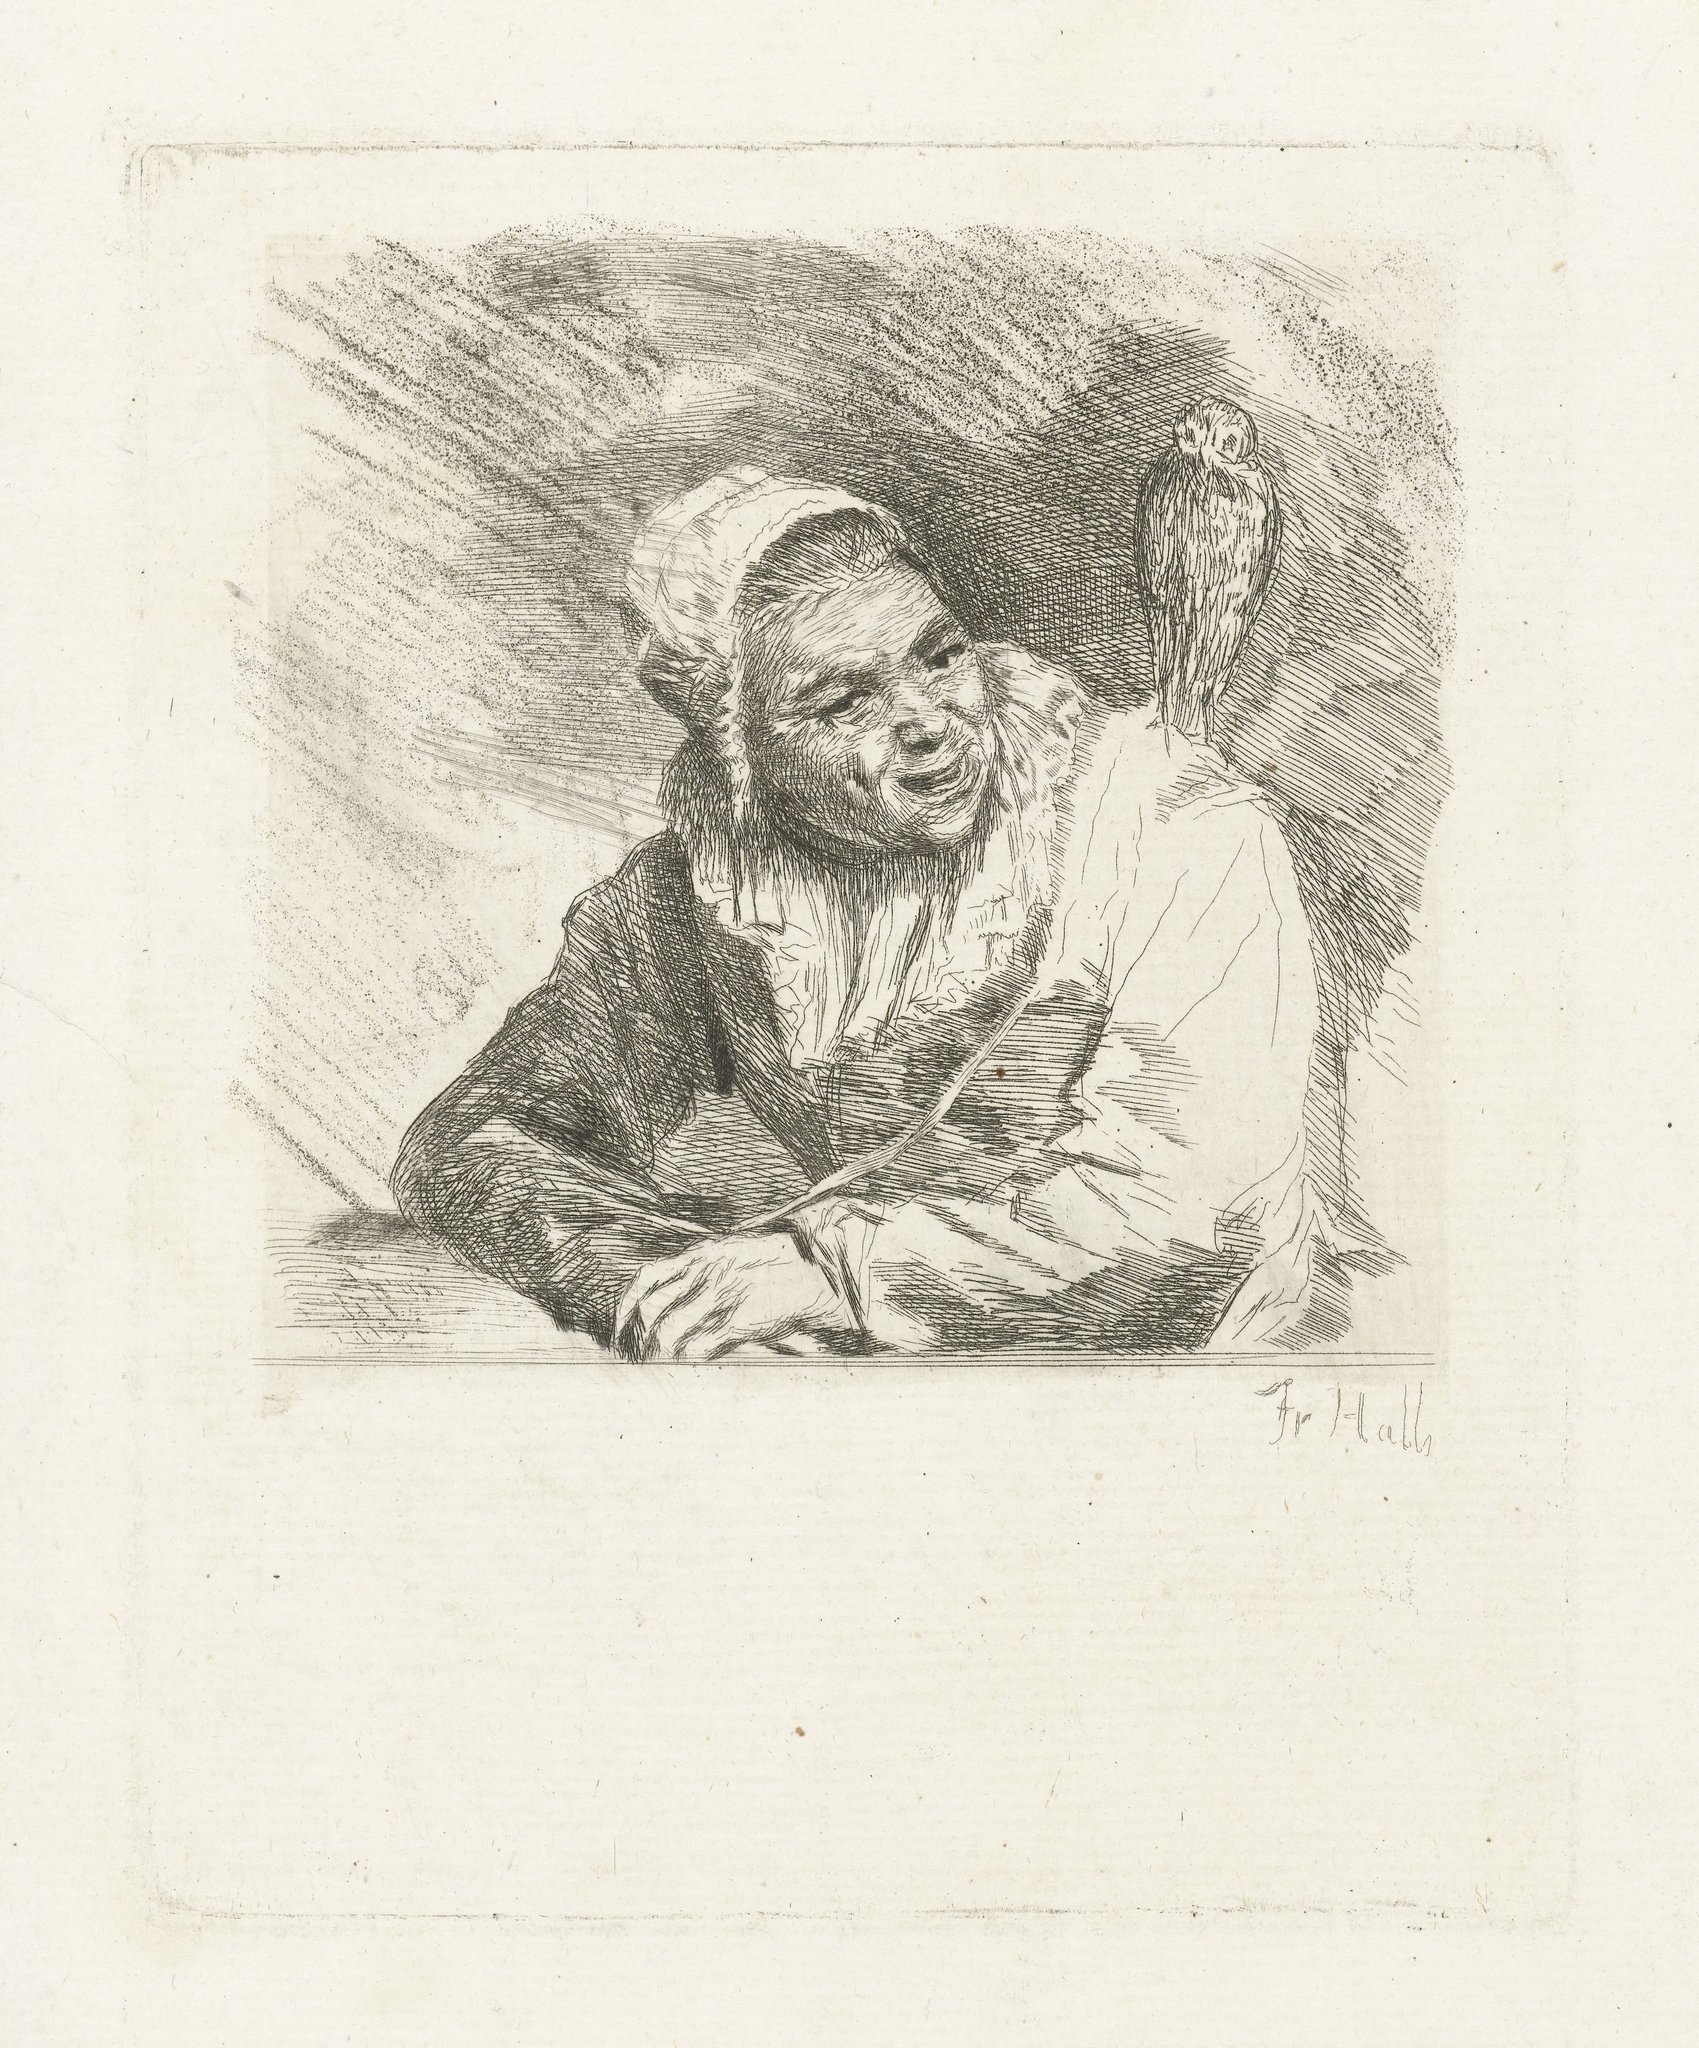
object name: print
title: Malle Babbe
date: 1756-1817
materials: paper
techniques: drypoint, roulette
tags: witch, sorceress, owls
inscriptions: collector's mark: Lugt 2228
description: Portretbuste van een lachende oude vrouw met wit kapje en kraag. Op haar schouder zit een uil.